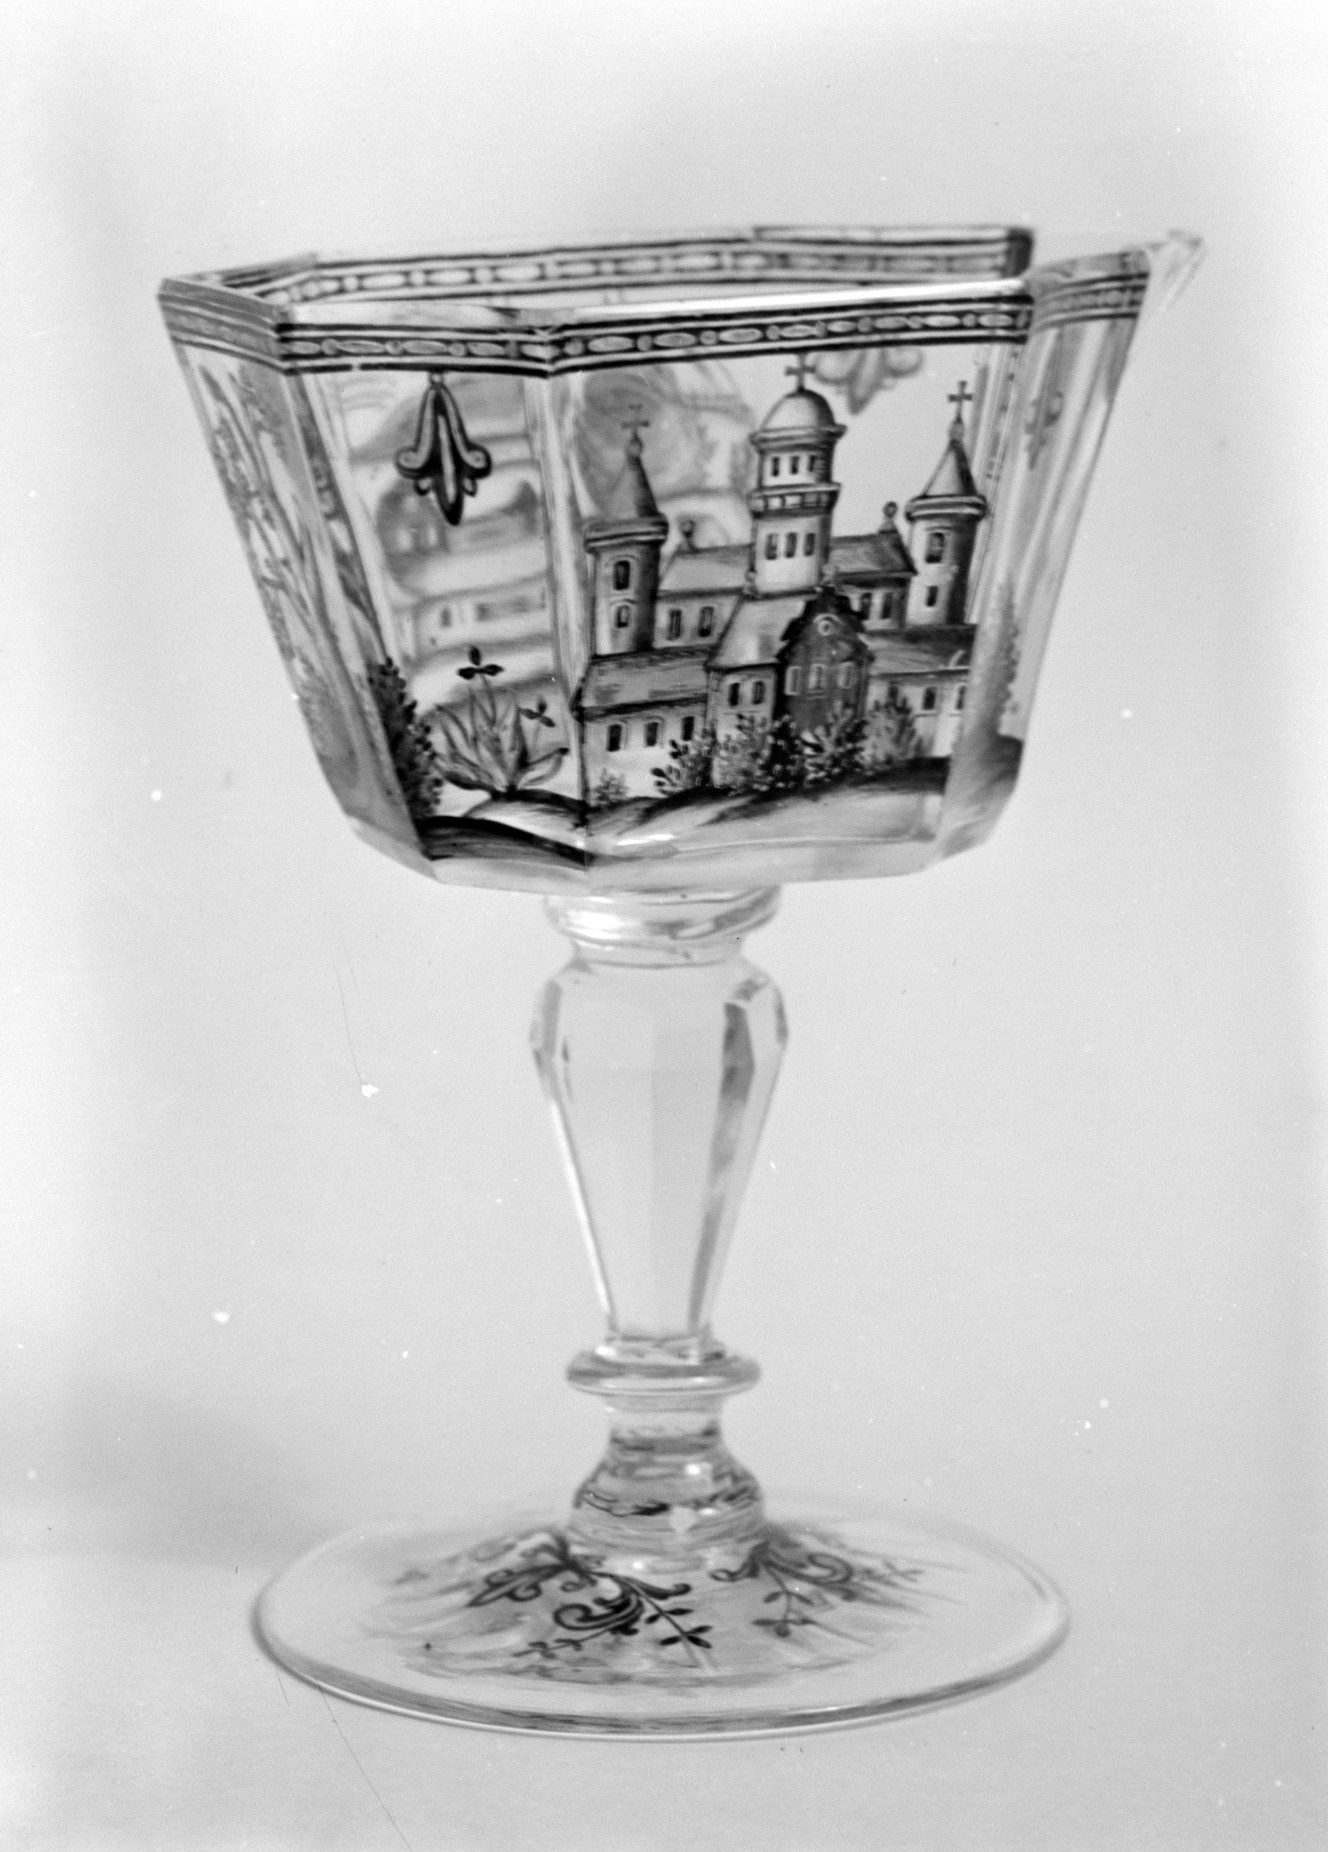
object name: sweetmeat glass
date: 1740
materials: glass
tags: buildings